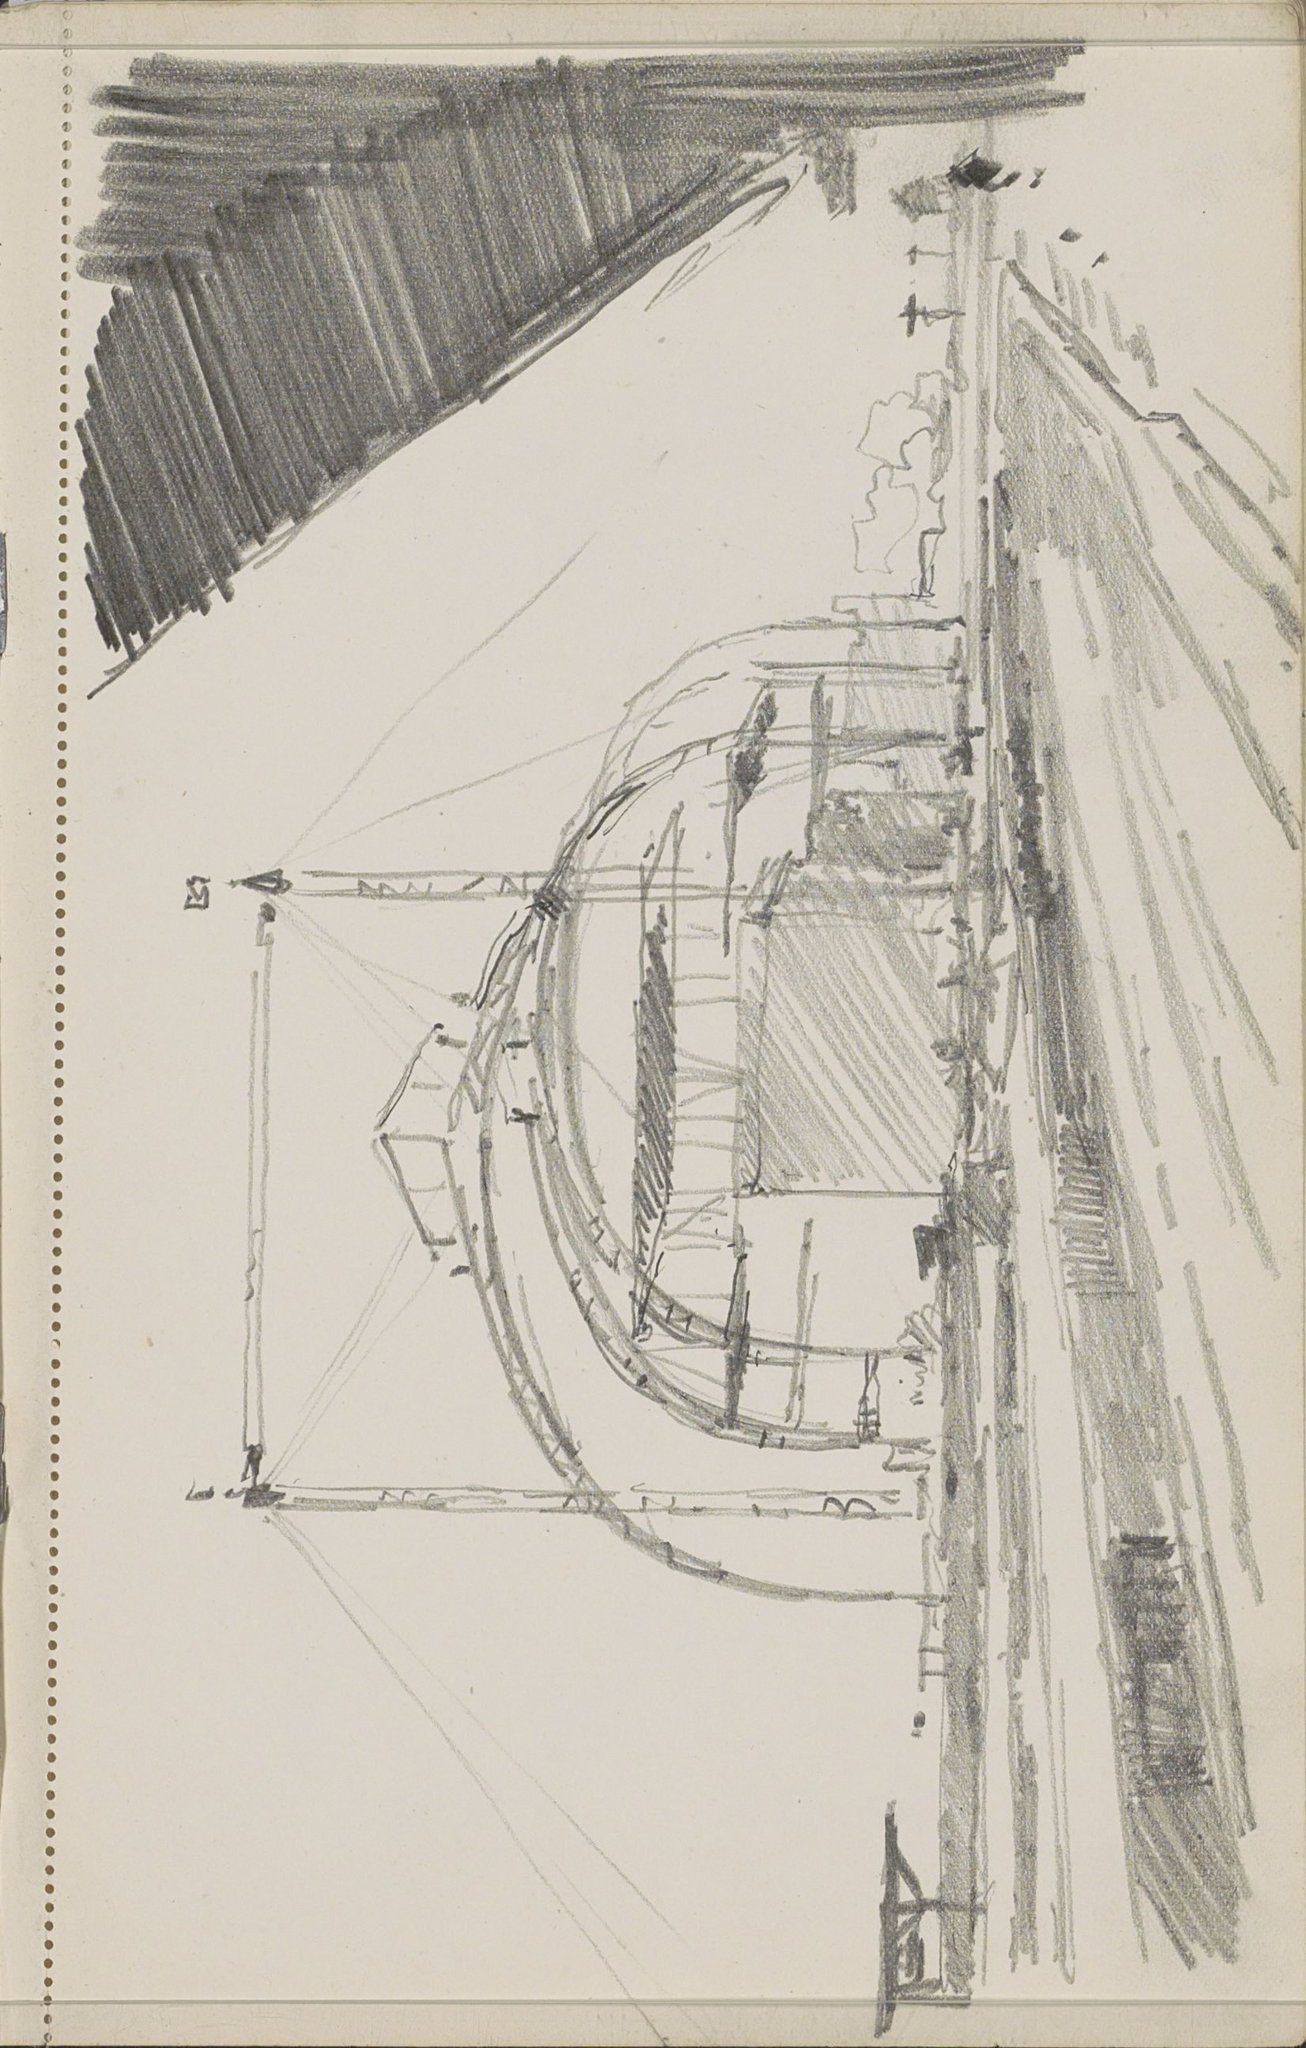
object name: sketchbook leaf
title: Deels overkoepeld treinstation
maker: cornelis vreedenburgh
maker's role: draughtsman, print maker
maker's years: 1880-1946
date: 1890-1946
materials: paper, pencil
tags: station; shelter (railway, tramway)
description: Blad 6 recto uit een schetsboek met 61 bladen.